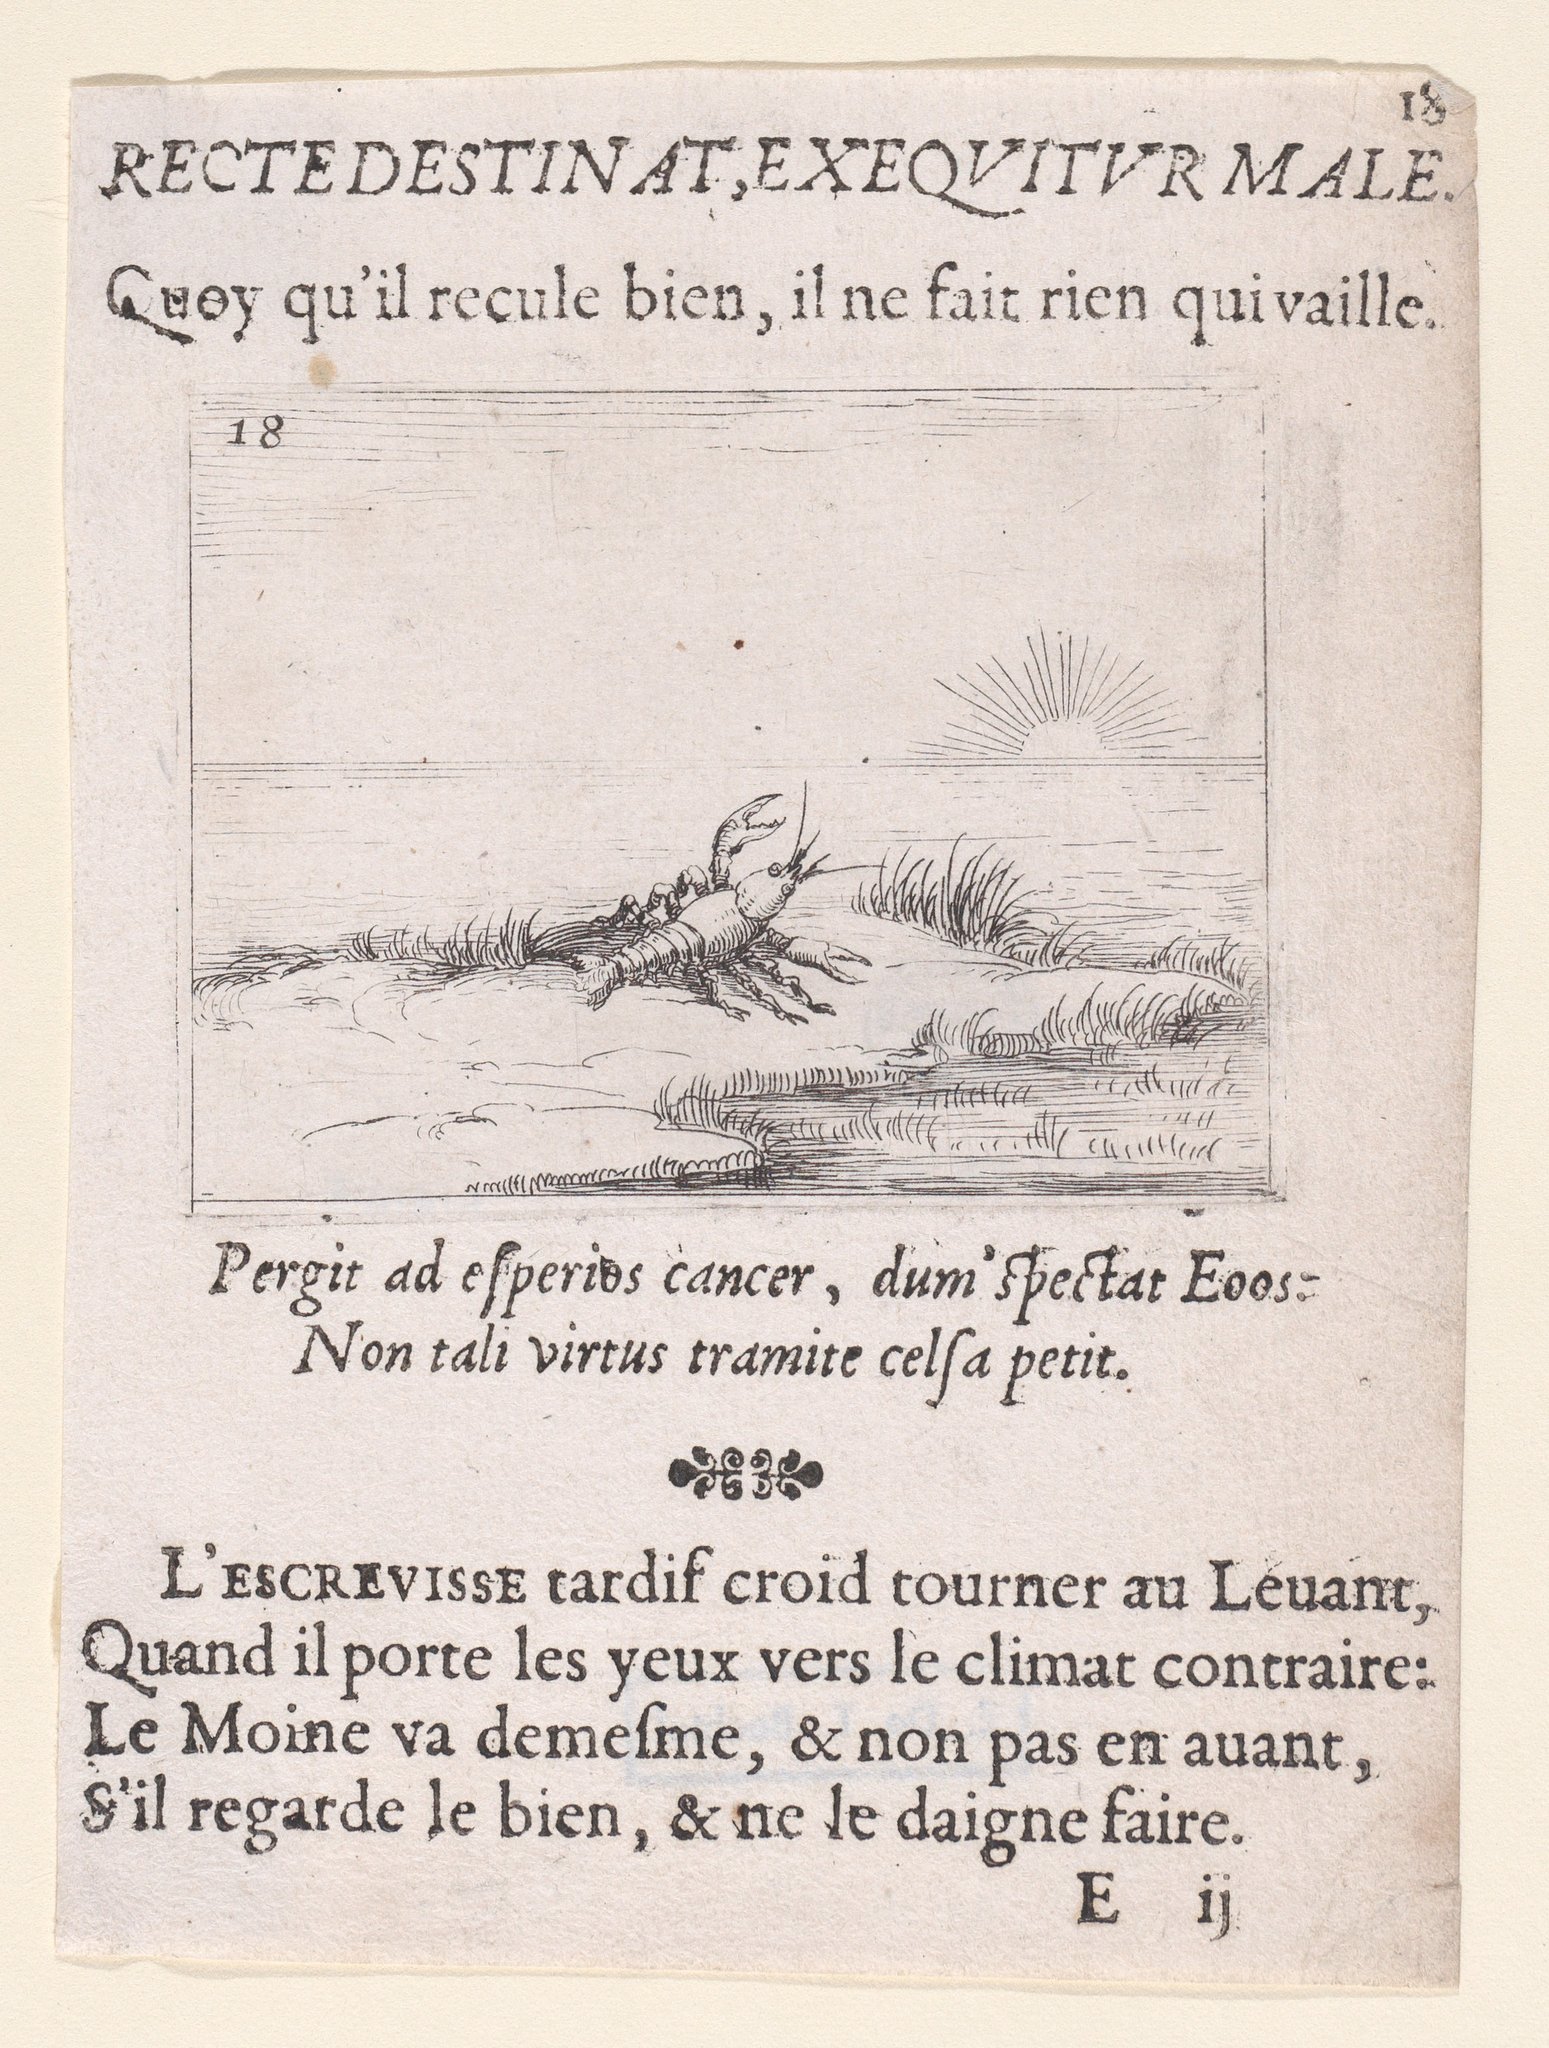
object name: print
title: Une Ecrevisse Regardant Le Soleil (A Crayfish Looking at the Sun), plate 18 from "Lux Claustri ou La Lumière du Cloitre" (The Light of the Cloisters)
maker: jacques callot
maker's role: artist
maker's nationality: french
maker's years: 1592-1635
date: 1621-1635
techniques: etching, letterpress